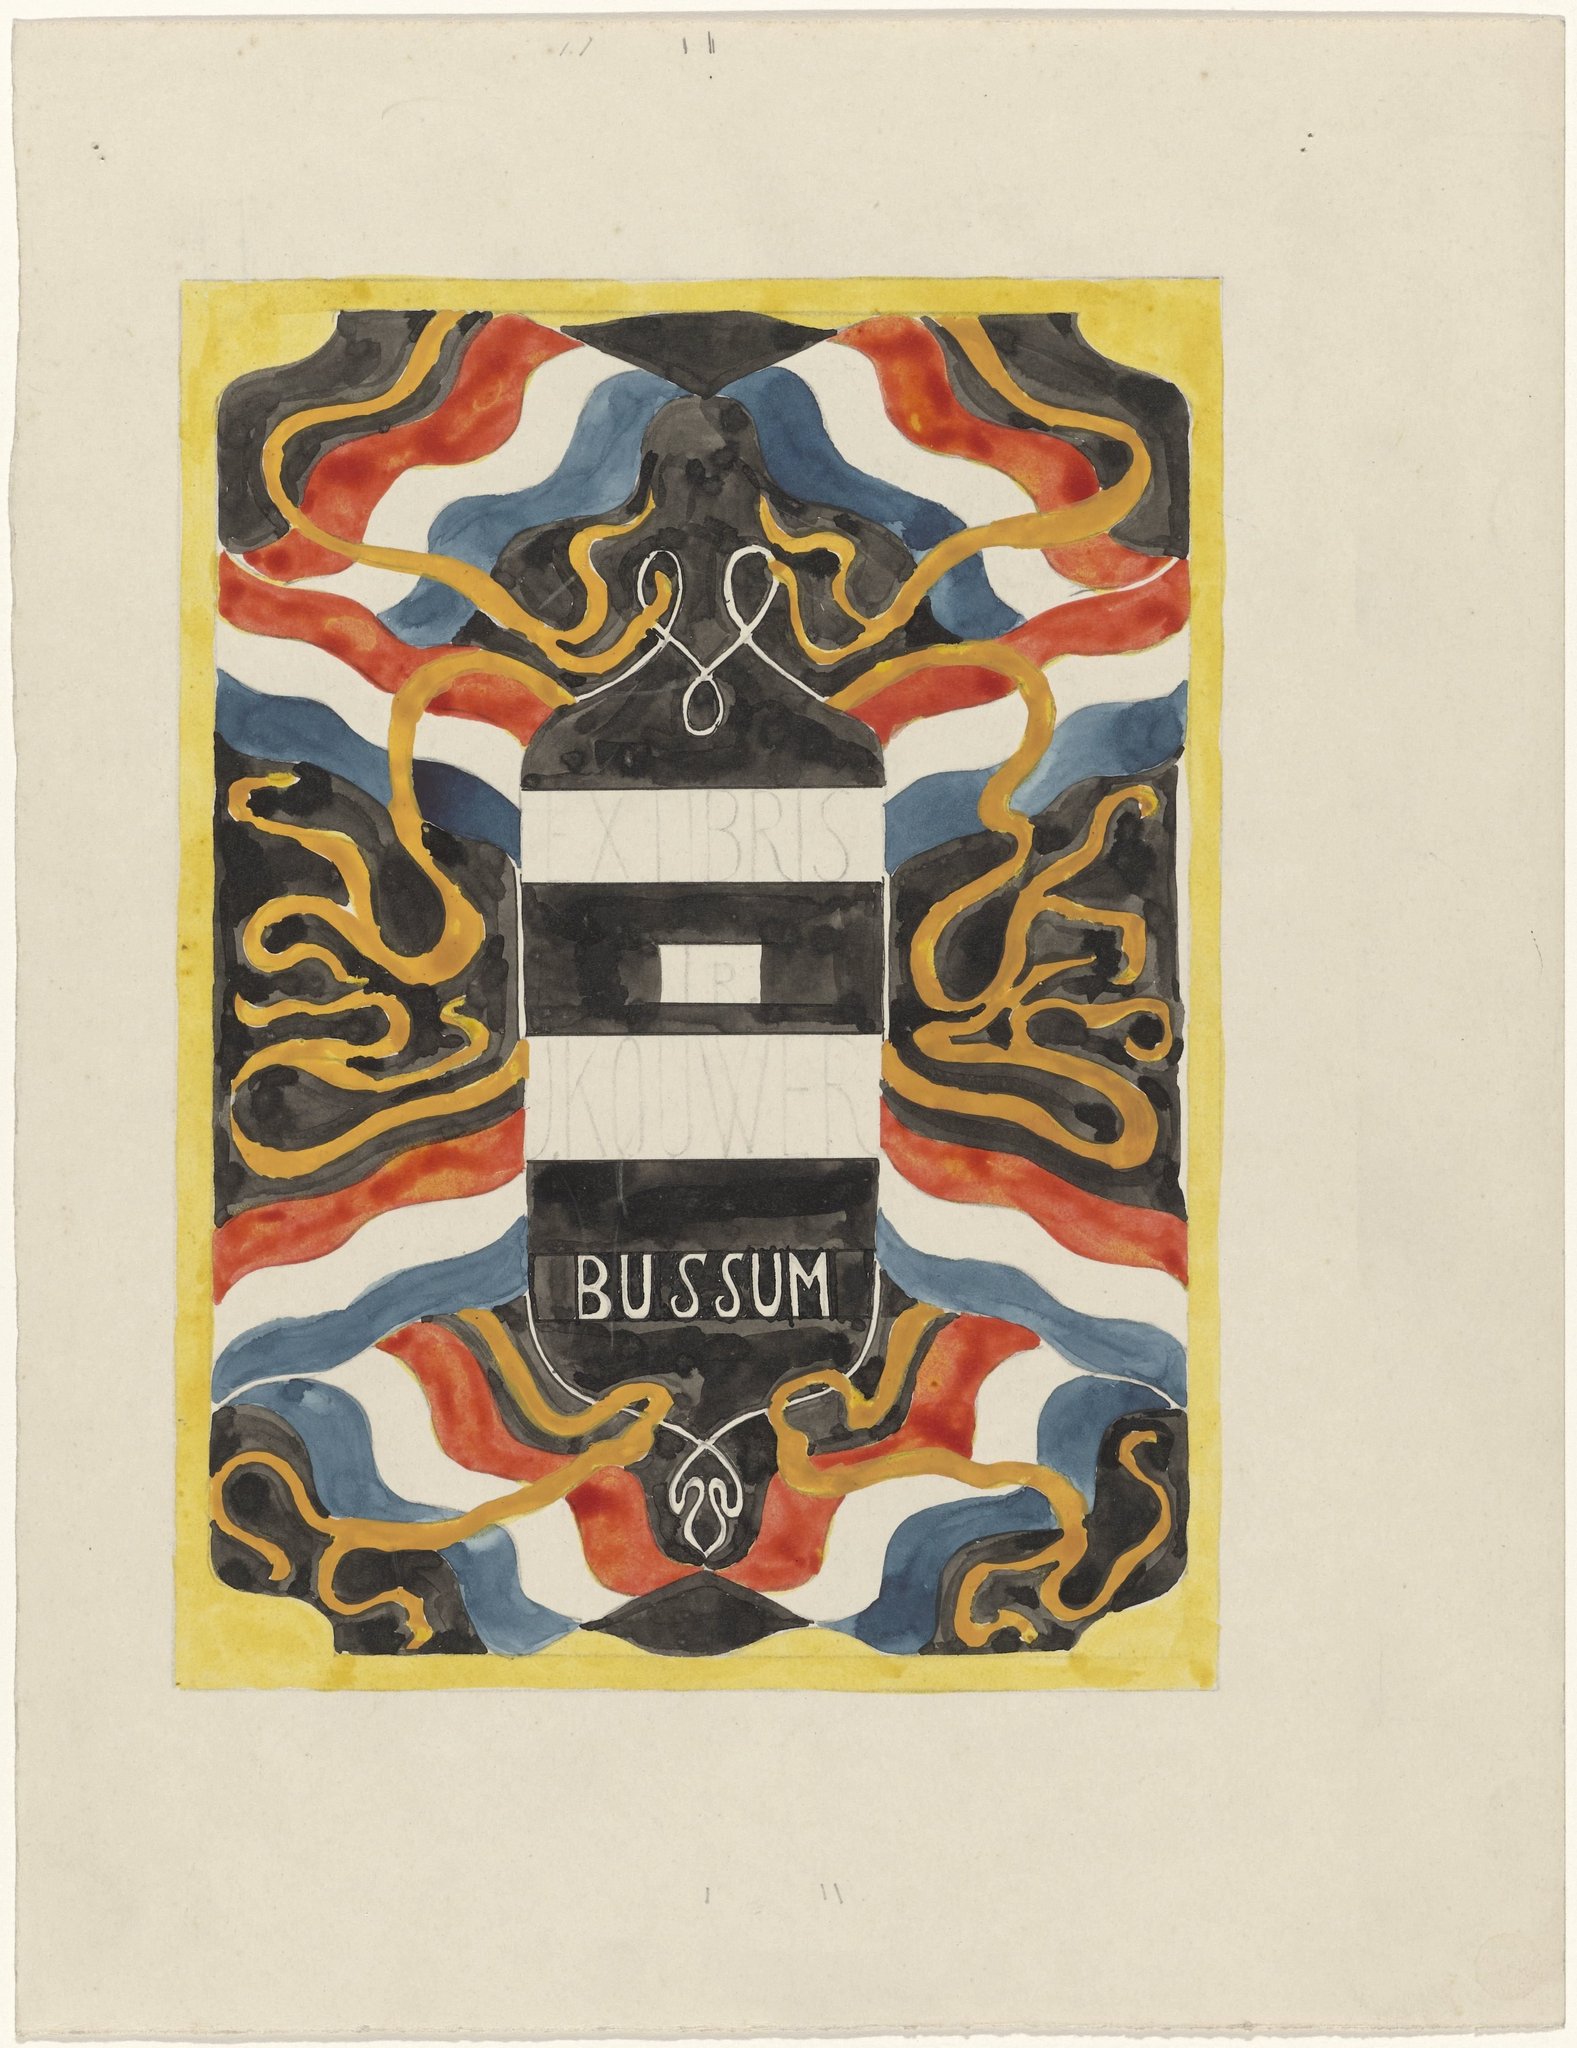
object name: design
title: Ontwerp voor ex libris van ingenieur J. Kouwer te Bussum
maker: carel adolph lion cachet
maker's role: draughtsman, print maker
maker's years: 1864-1945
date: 1874-1945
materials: paper, pencil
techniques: brush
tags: engineer, ex-libris